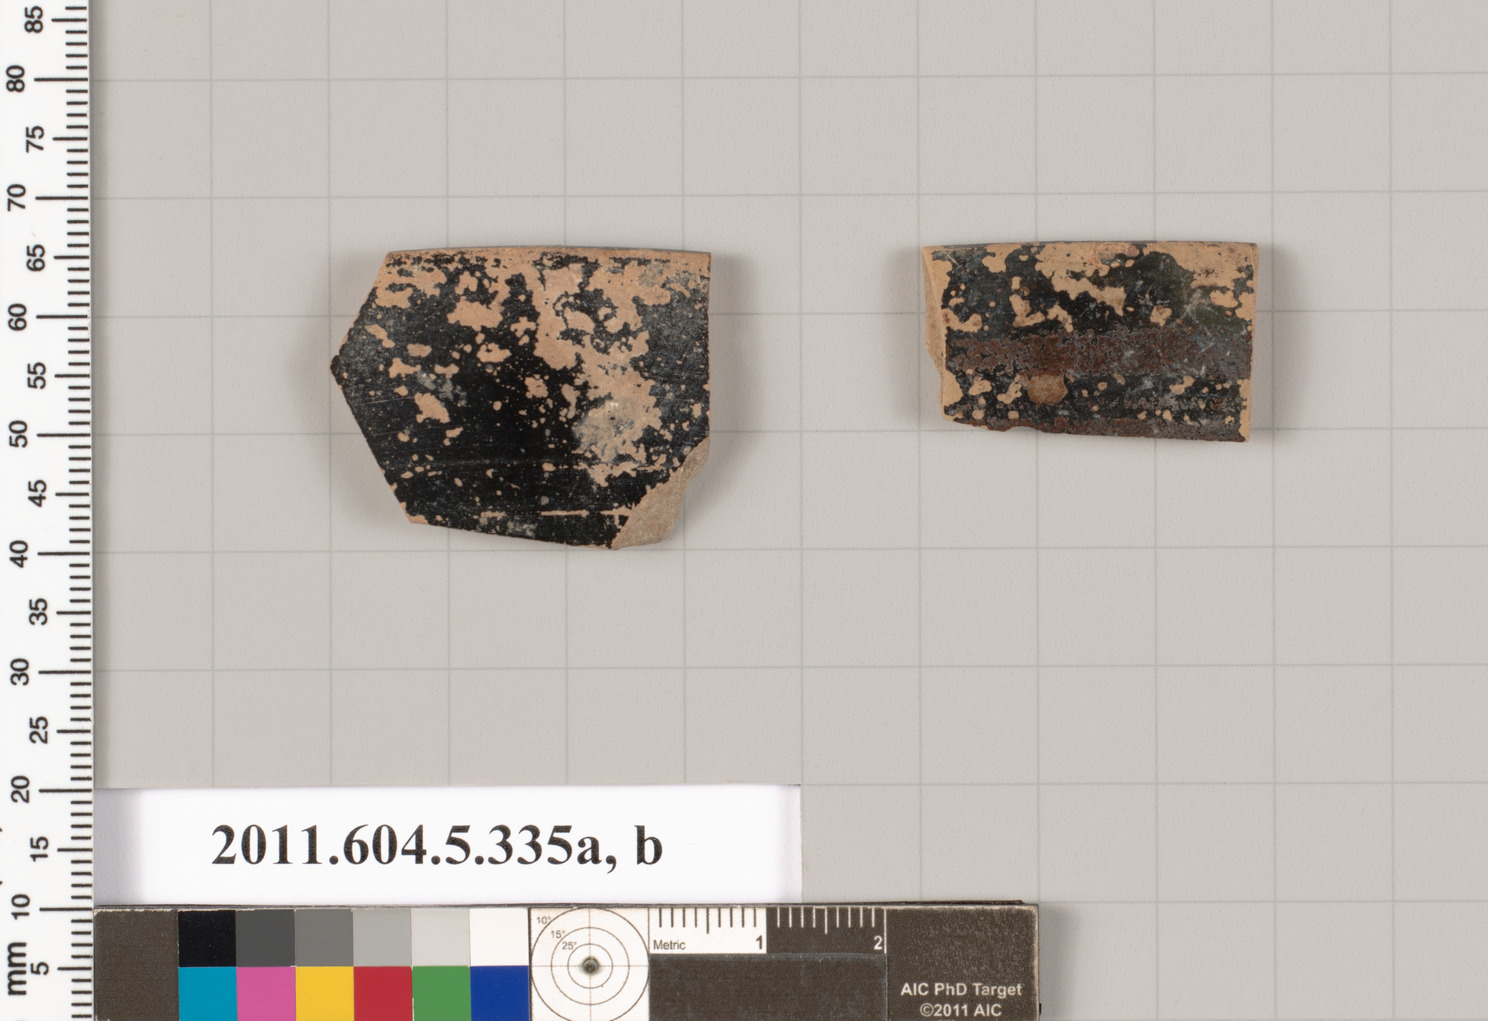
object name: kylix fragment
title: Terracotta rim fragments of kylikes (drinking cups)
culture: greek, attic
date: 600-401 BCE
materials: terracotta